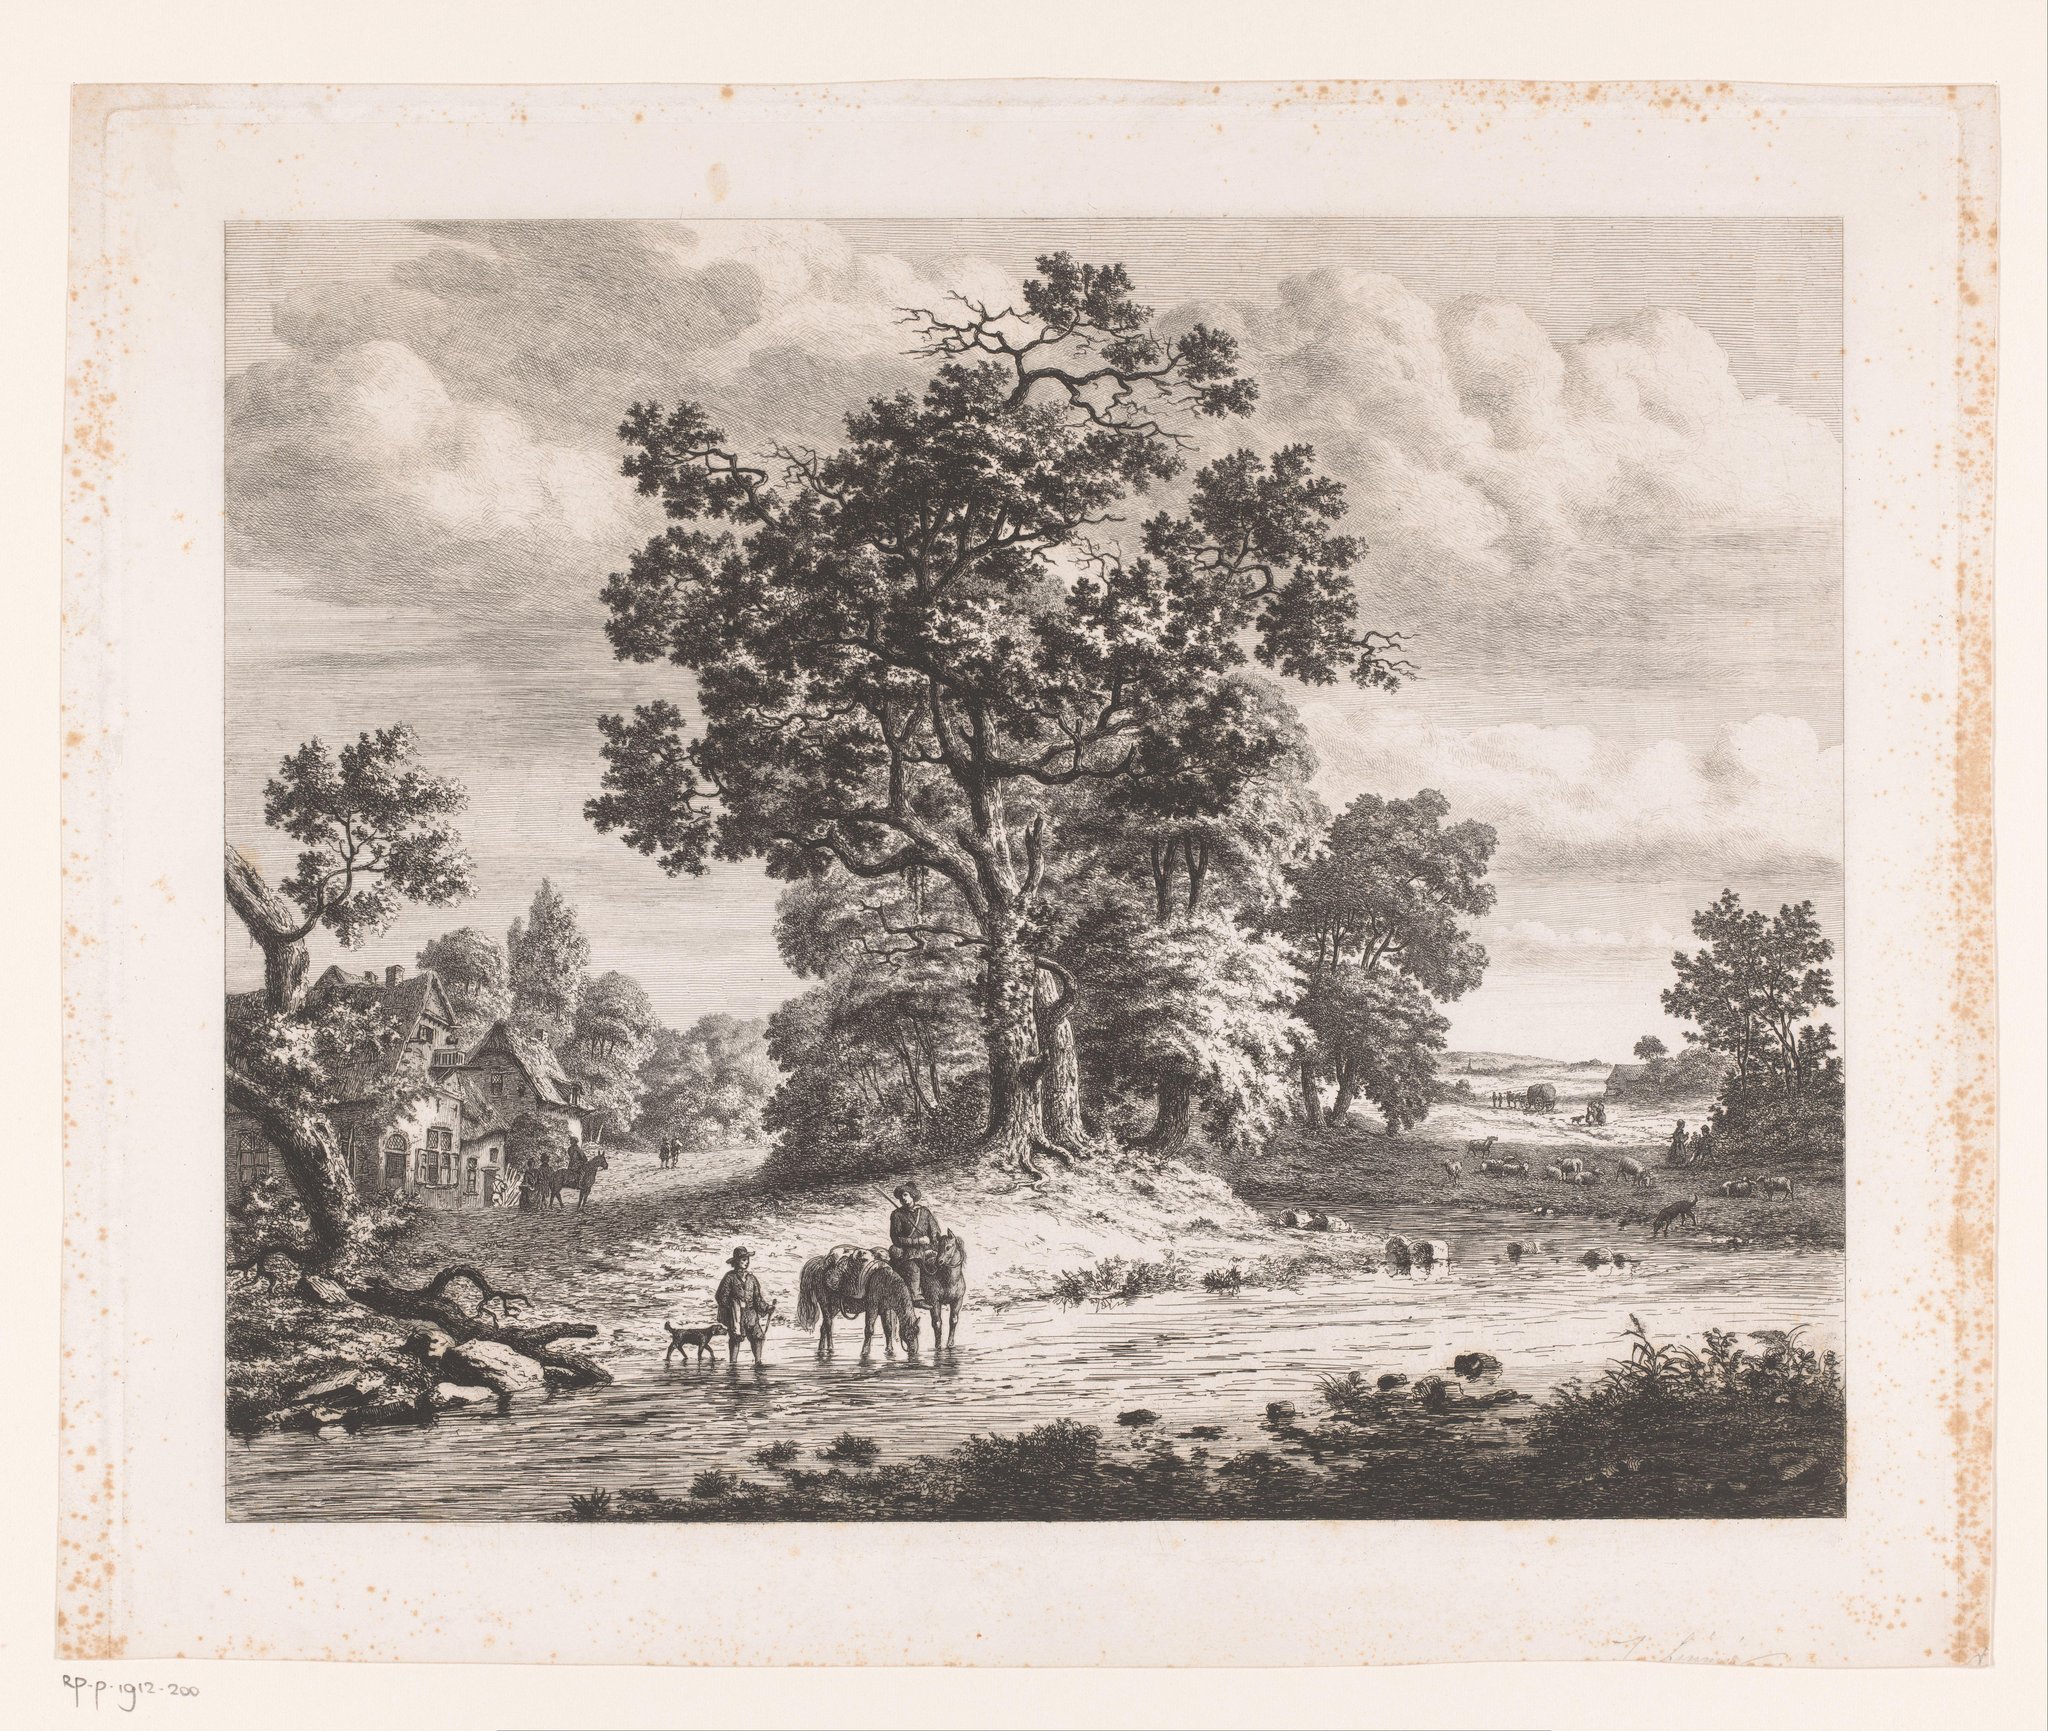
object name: print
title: Landschap langs de Samber, een ruiter met twee paarden in het water naast een man met een hond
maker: jean théodore joseph linnig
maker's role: draughtsman, print maker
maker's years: 1815-1891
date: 1856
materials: paper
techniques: etching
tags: river (+ landscape with figures, staffage)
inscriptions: collector's mark: Lugt 2228